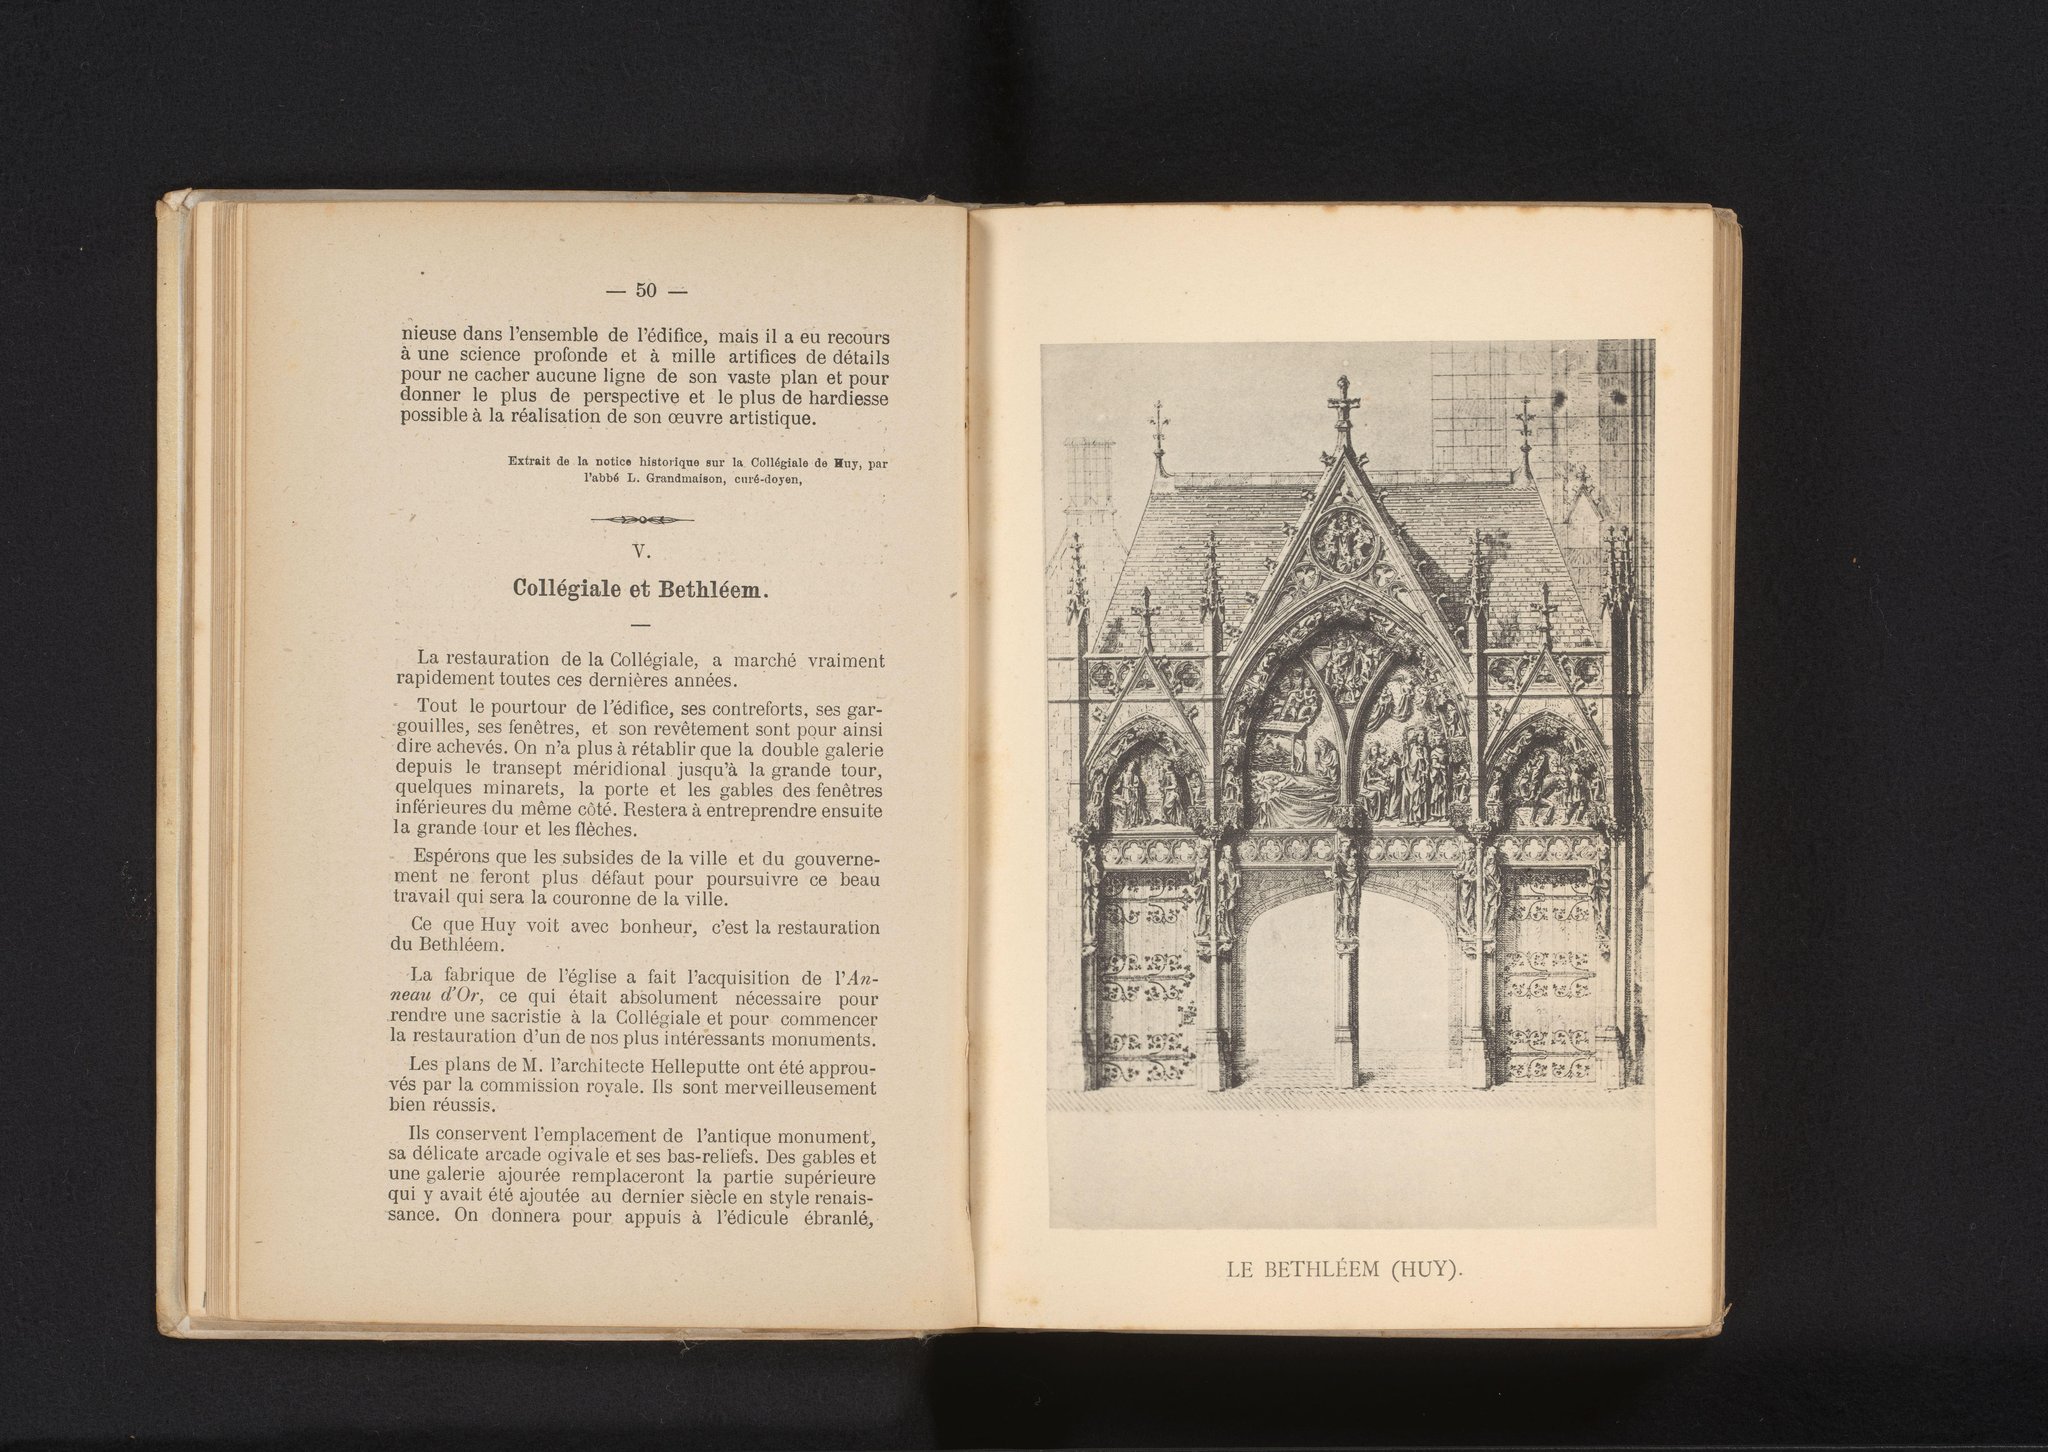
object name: reproduction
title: Huy. - Le Bethléem (Huy)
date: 1885-1890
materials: paper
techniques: photograph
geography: brussels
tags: church (exterior)